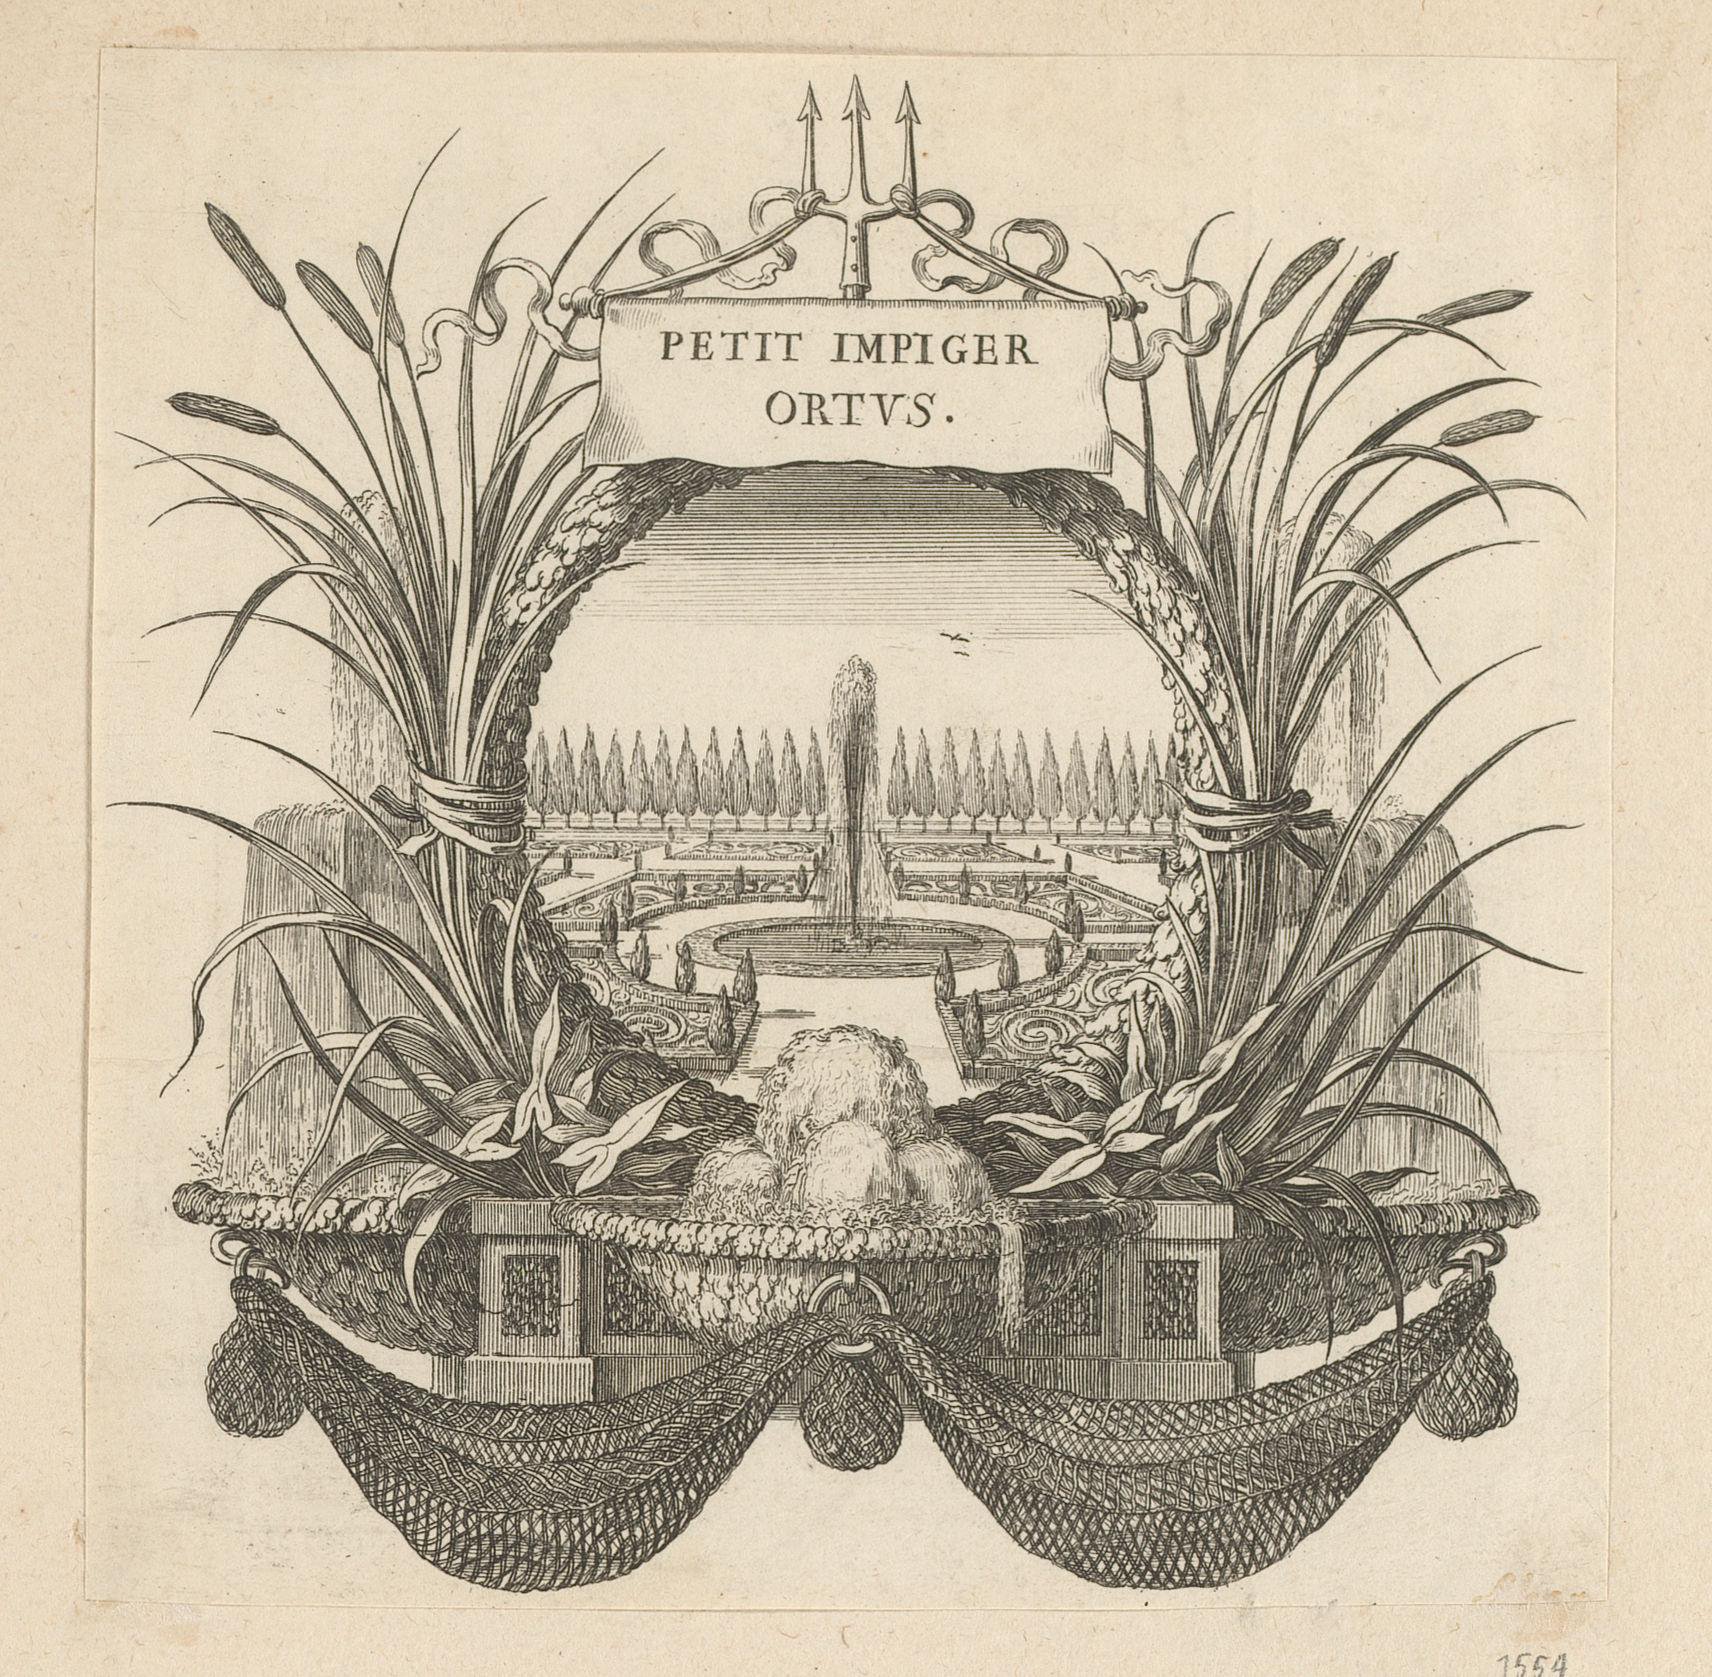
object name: print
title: Fontein in een cartouche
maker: sébastien leclerc (i)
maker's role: print maker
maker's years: 1637-1714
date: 1670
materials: paper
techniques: etching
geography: paris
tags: garden fountain, plants and herbs: reed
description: Prent gebruikt voor: Félibien, André. Devises pour les tapisseries du Roy, où sont représentez les quatre éléments et les quatre saisons de l'année (...). Parijs: Imprimerie Royale, 1670.